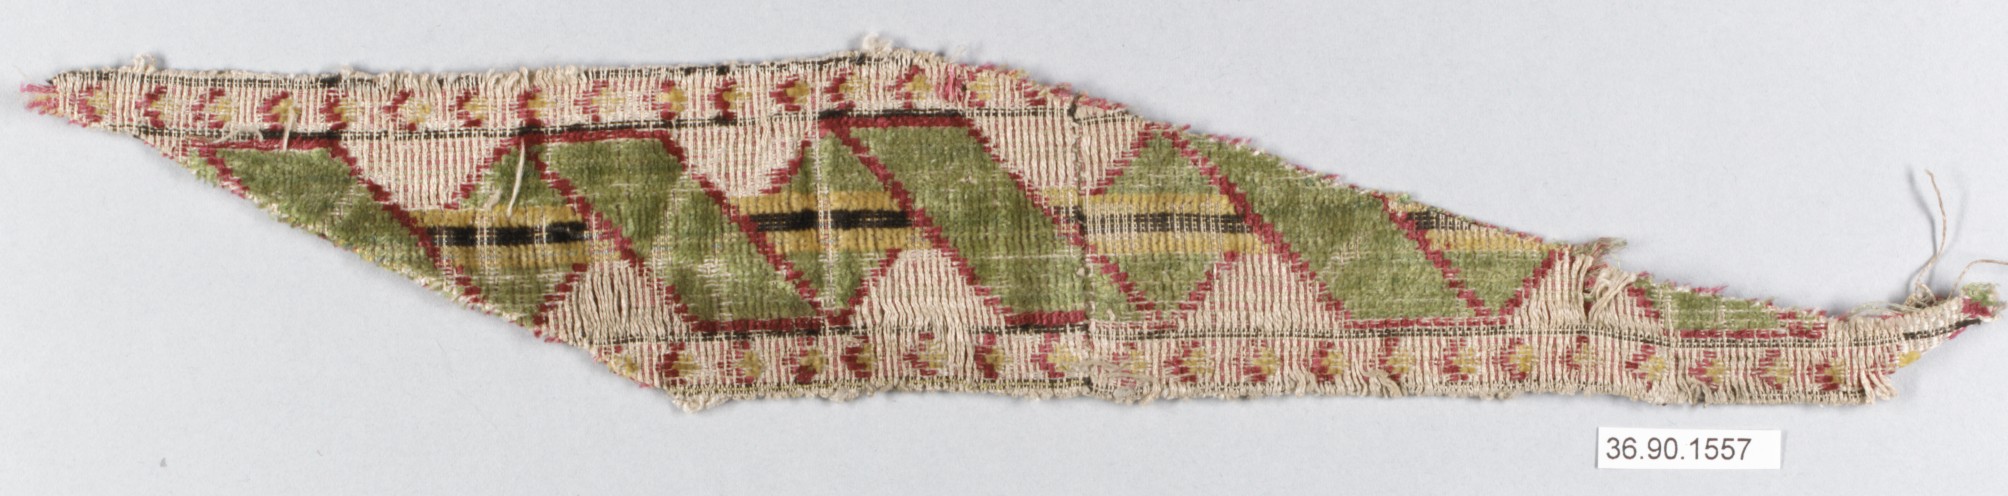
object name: galloon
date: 1701-1900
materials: silk